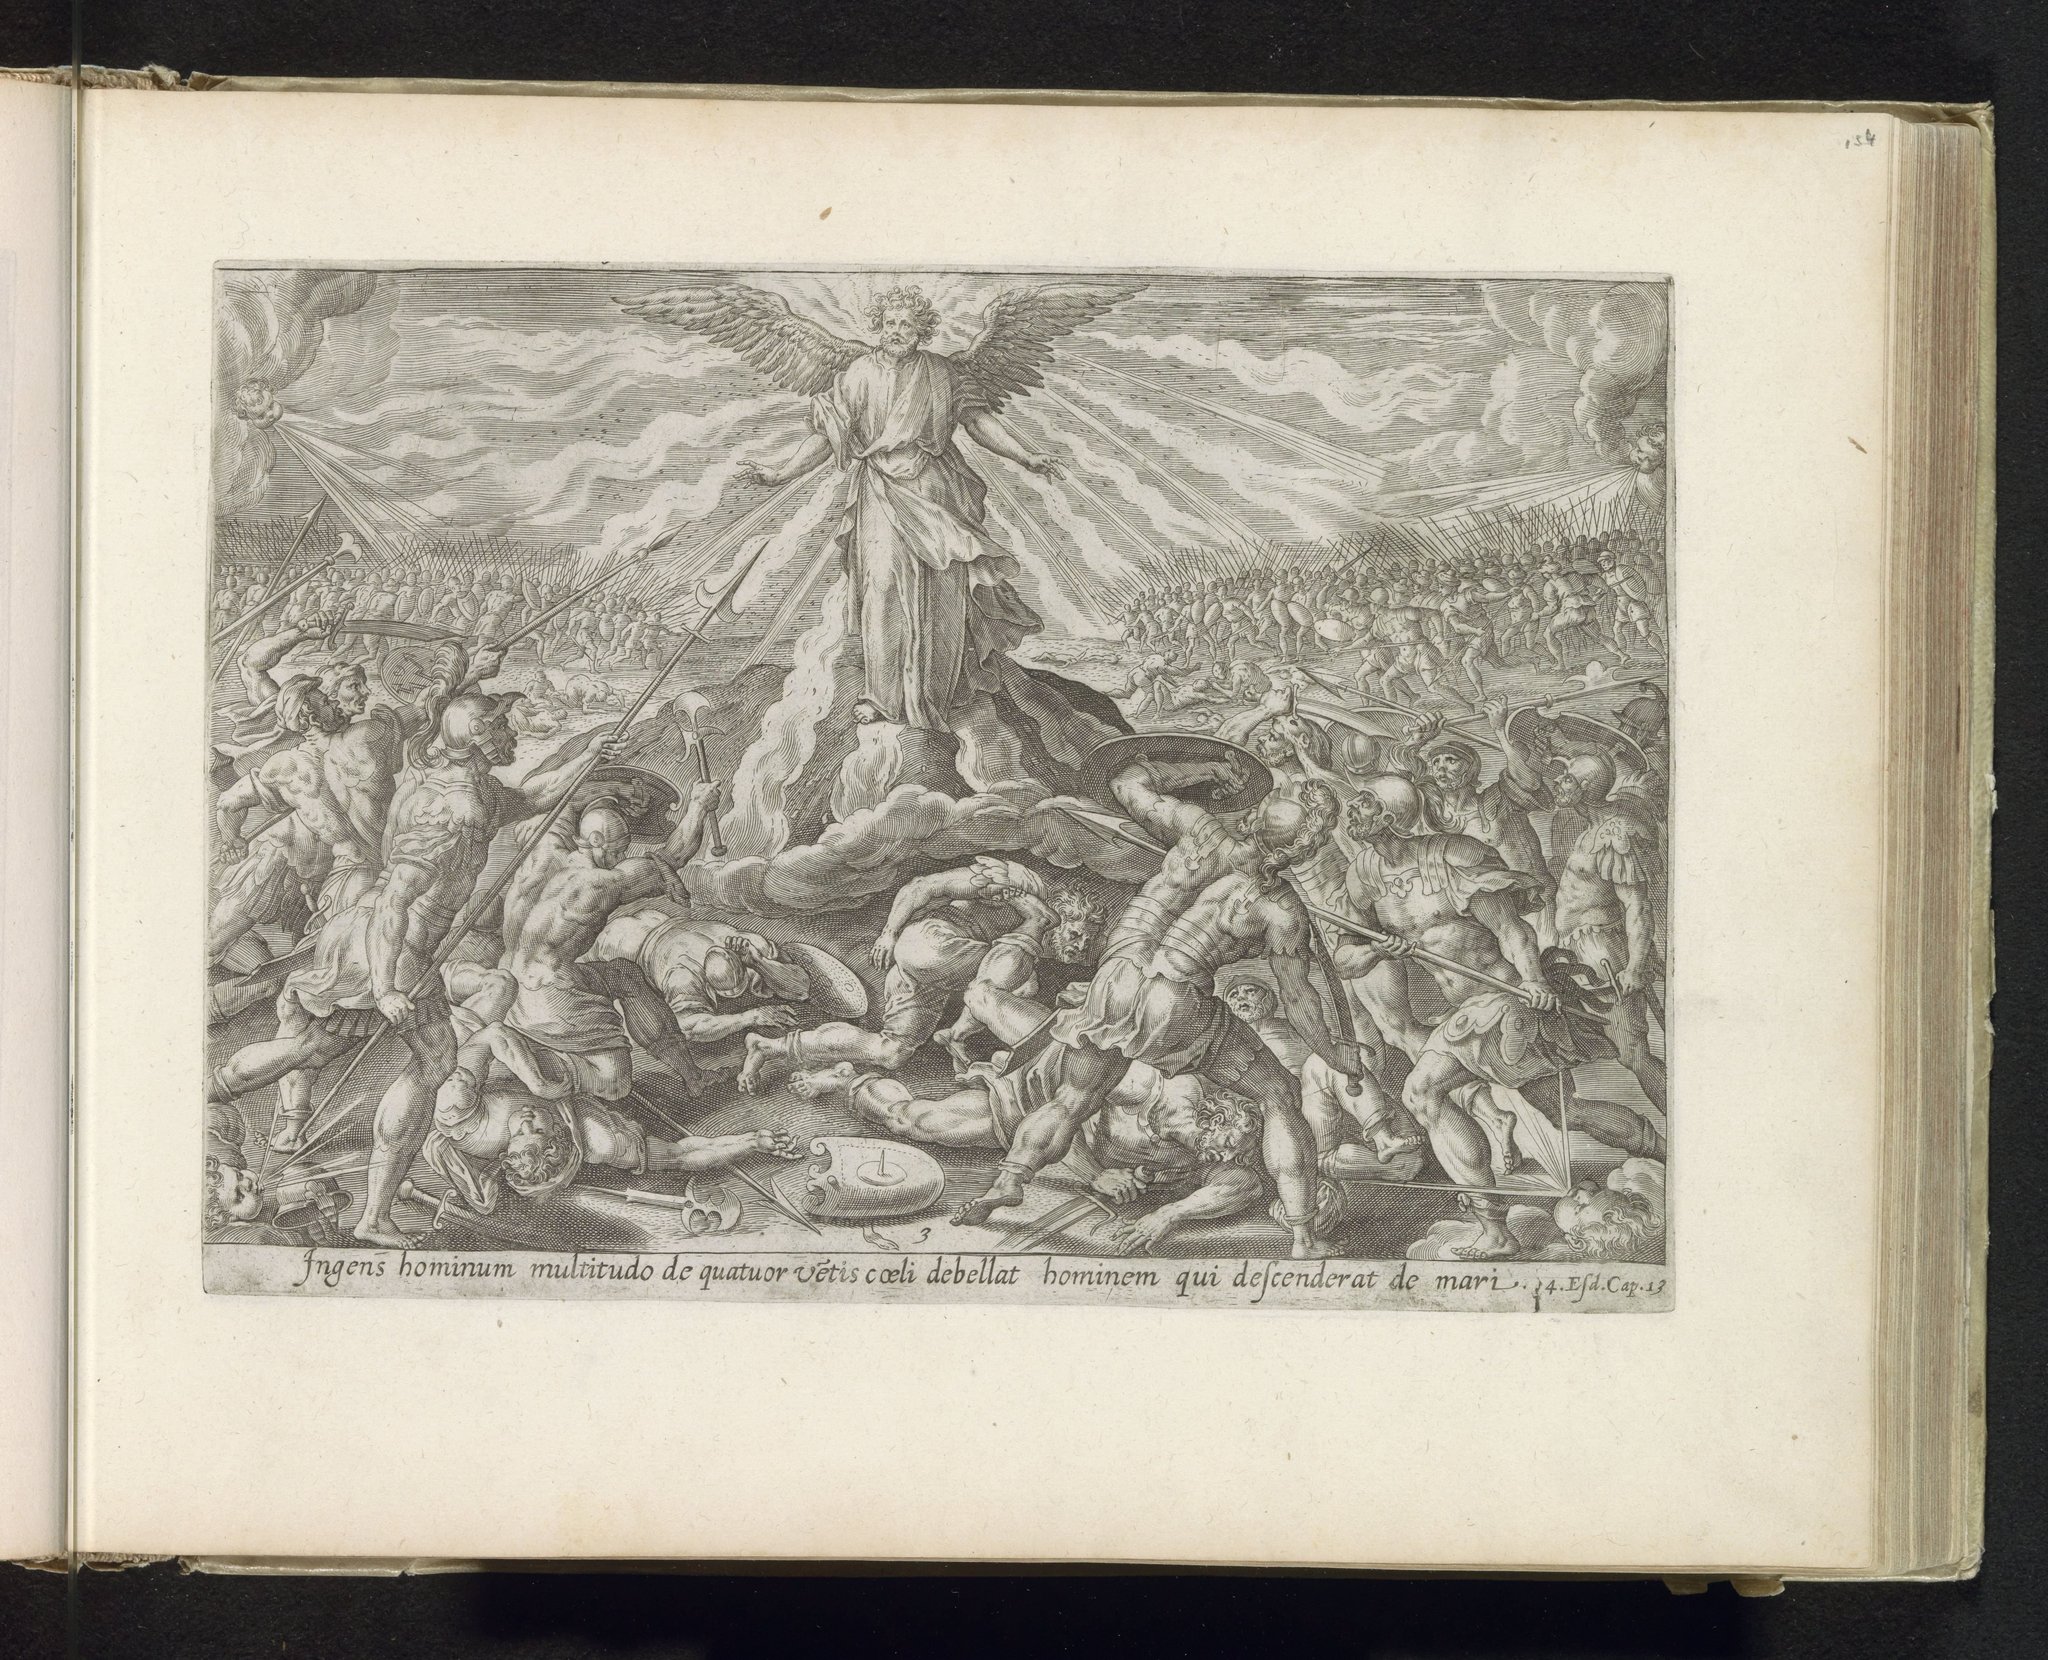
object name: album leaf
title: Derde visioen van Ezra: de menigte vecht tegen de man uit de zee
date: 1585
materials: paper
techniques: engraving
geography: antwerp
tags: other scenes from ezra and esdras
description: Het derde visioen van Ezra. Hij ziet een menigte mensen vechten tegen een gevleugelde man, die op een berg is gevlucht. Onder de voorstelling een verwijzing in het Latijn naar de apocriefe Bijbeltekst in 4 Ezra 13. Deze prent maakt deel uit van een album.